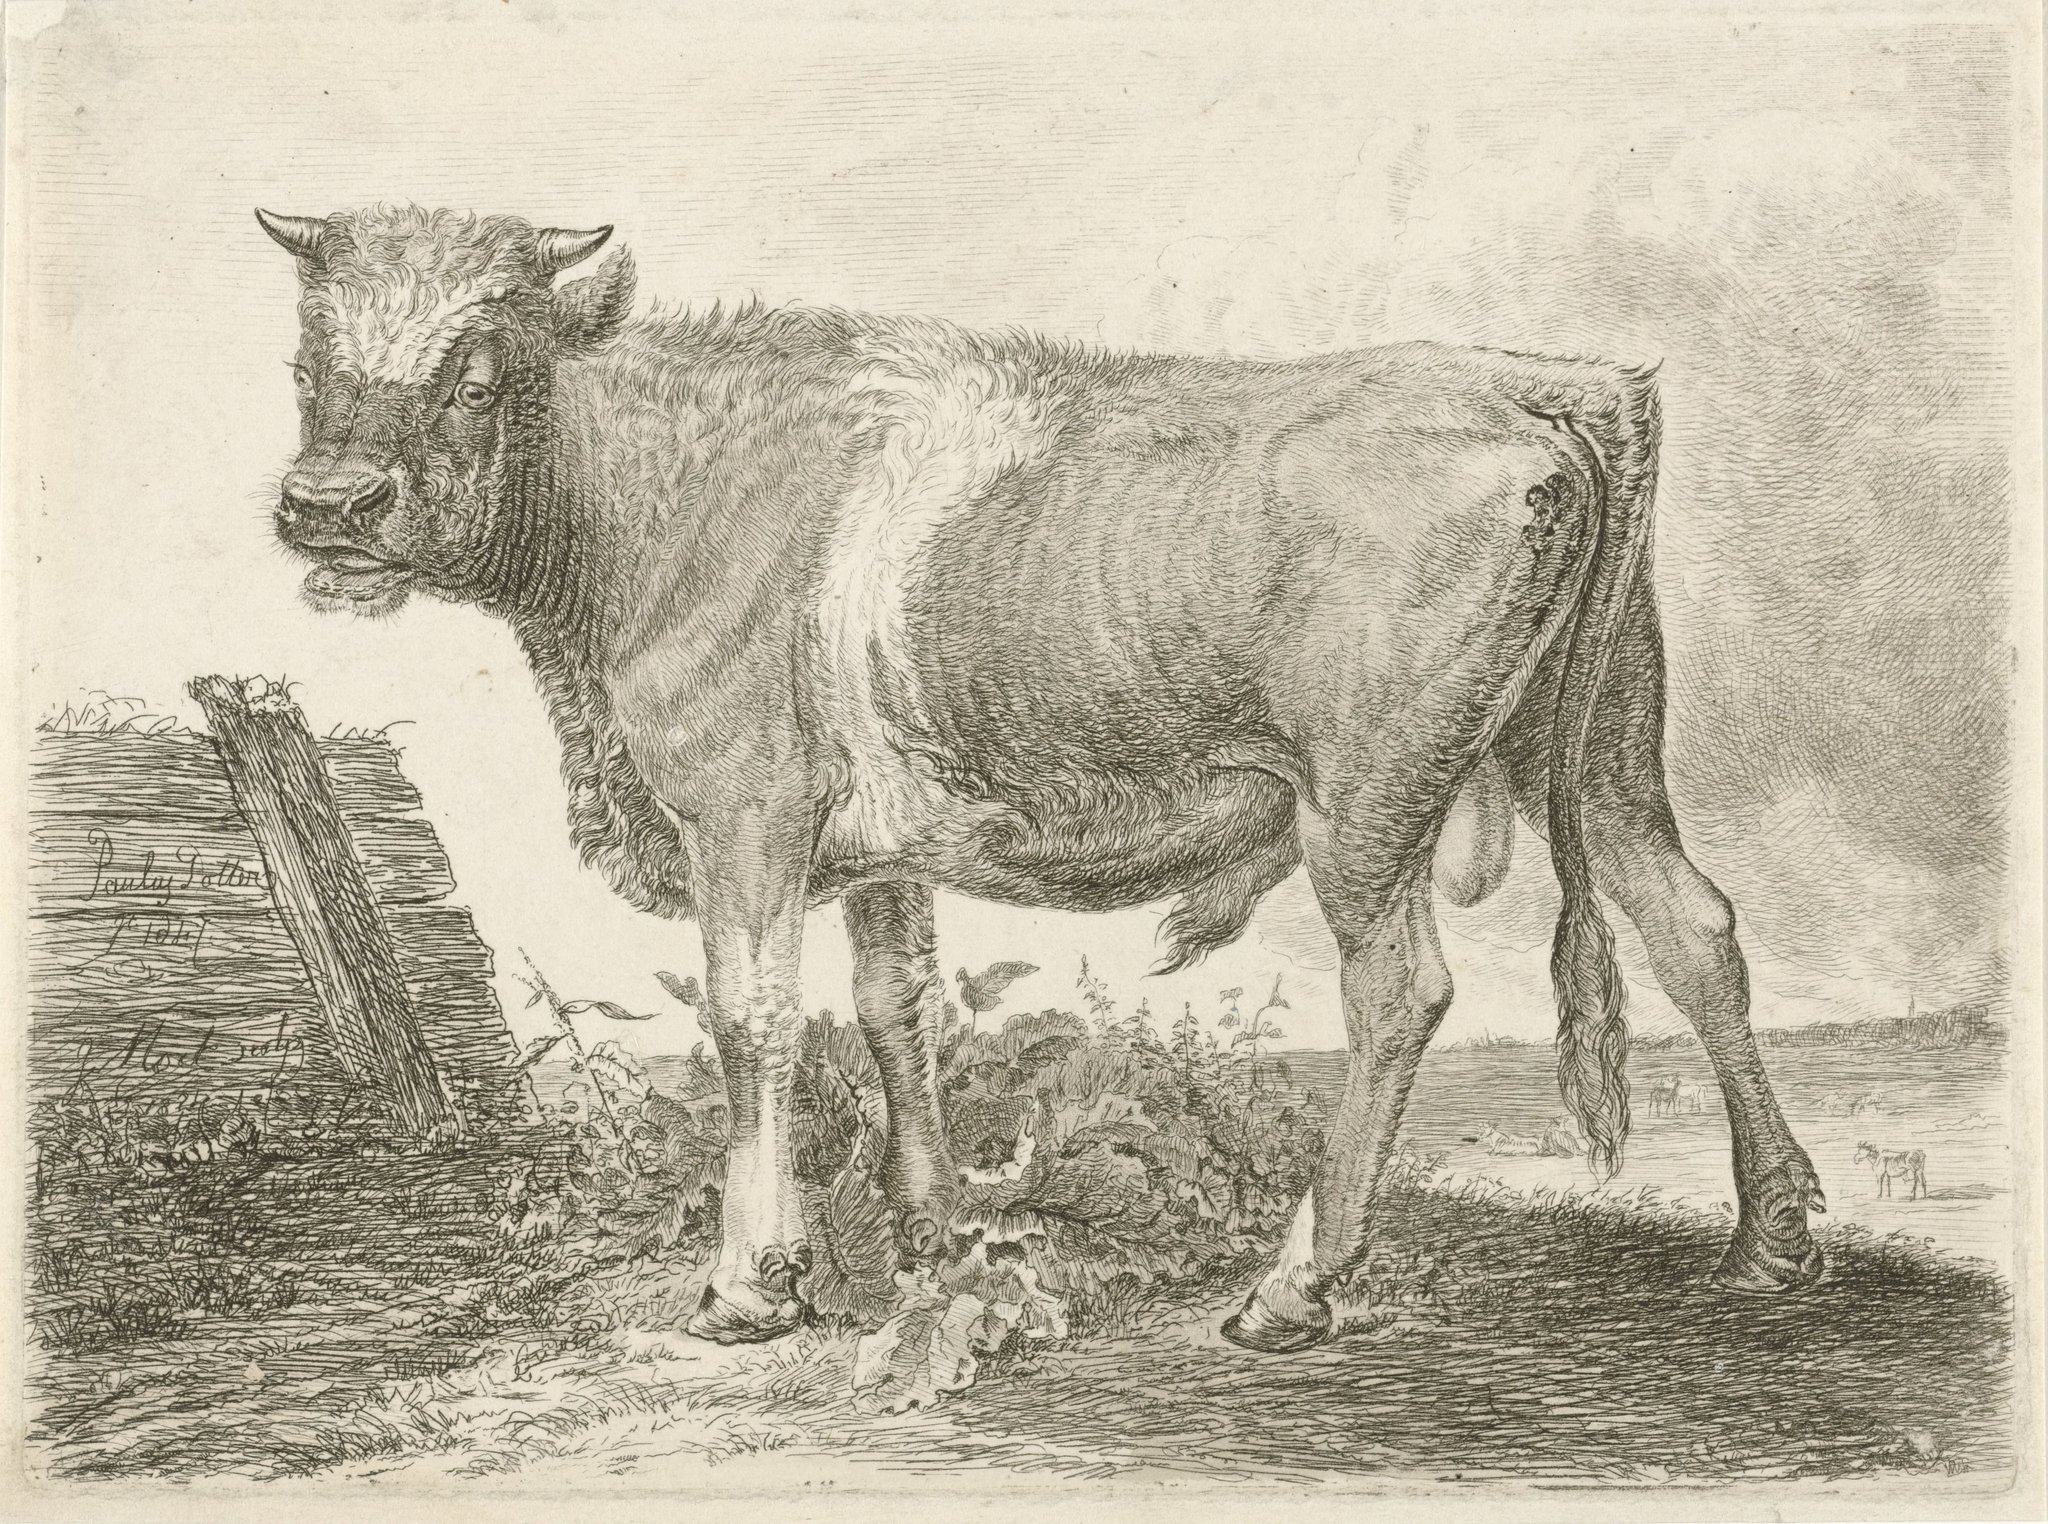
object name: print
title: Stier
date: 1824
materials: paper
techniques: etching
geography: netherlands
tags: bull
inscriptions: collector's mark: Lugt 2228